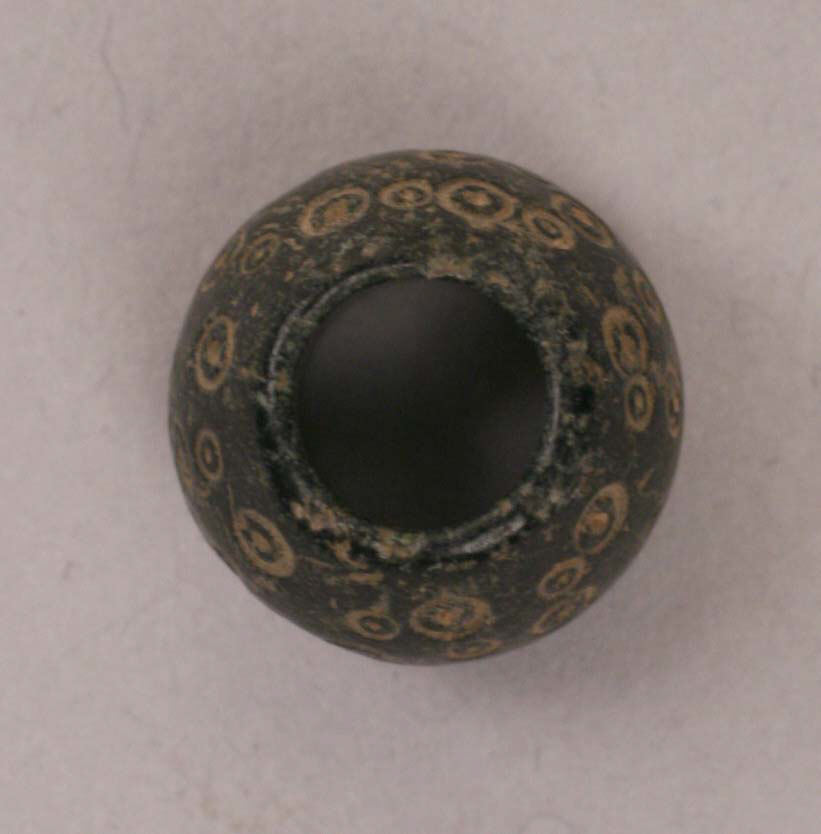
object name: button or bead or spindle whorl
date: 701-1000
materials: stone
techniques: incising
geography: iran